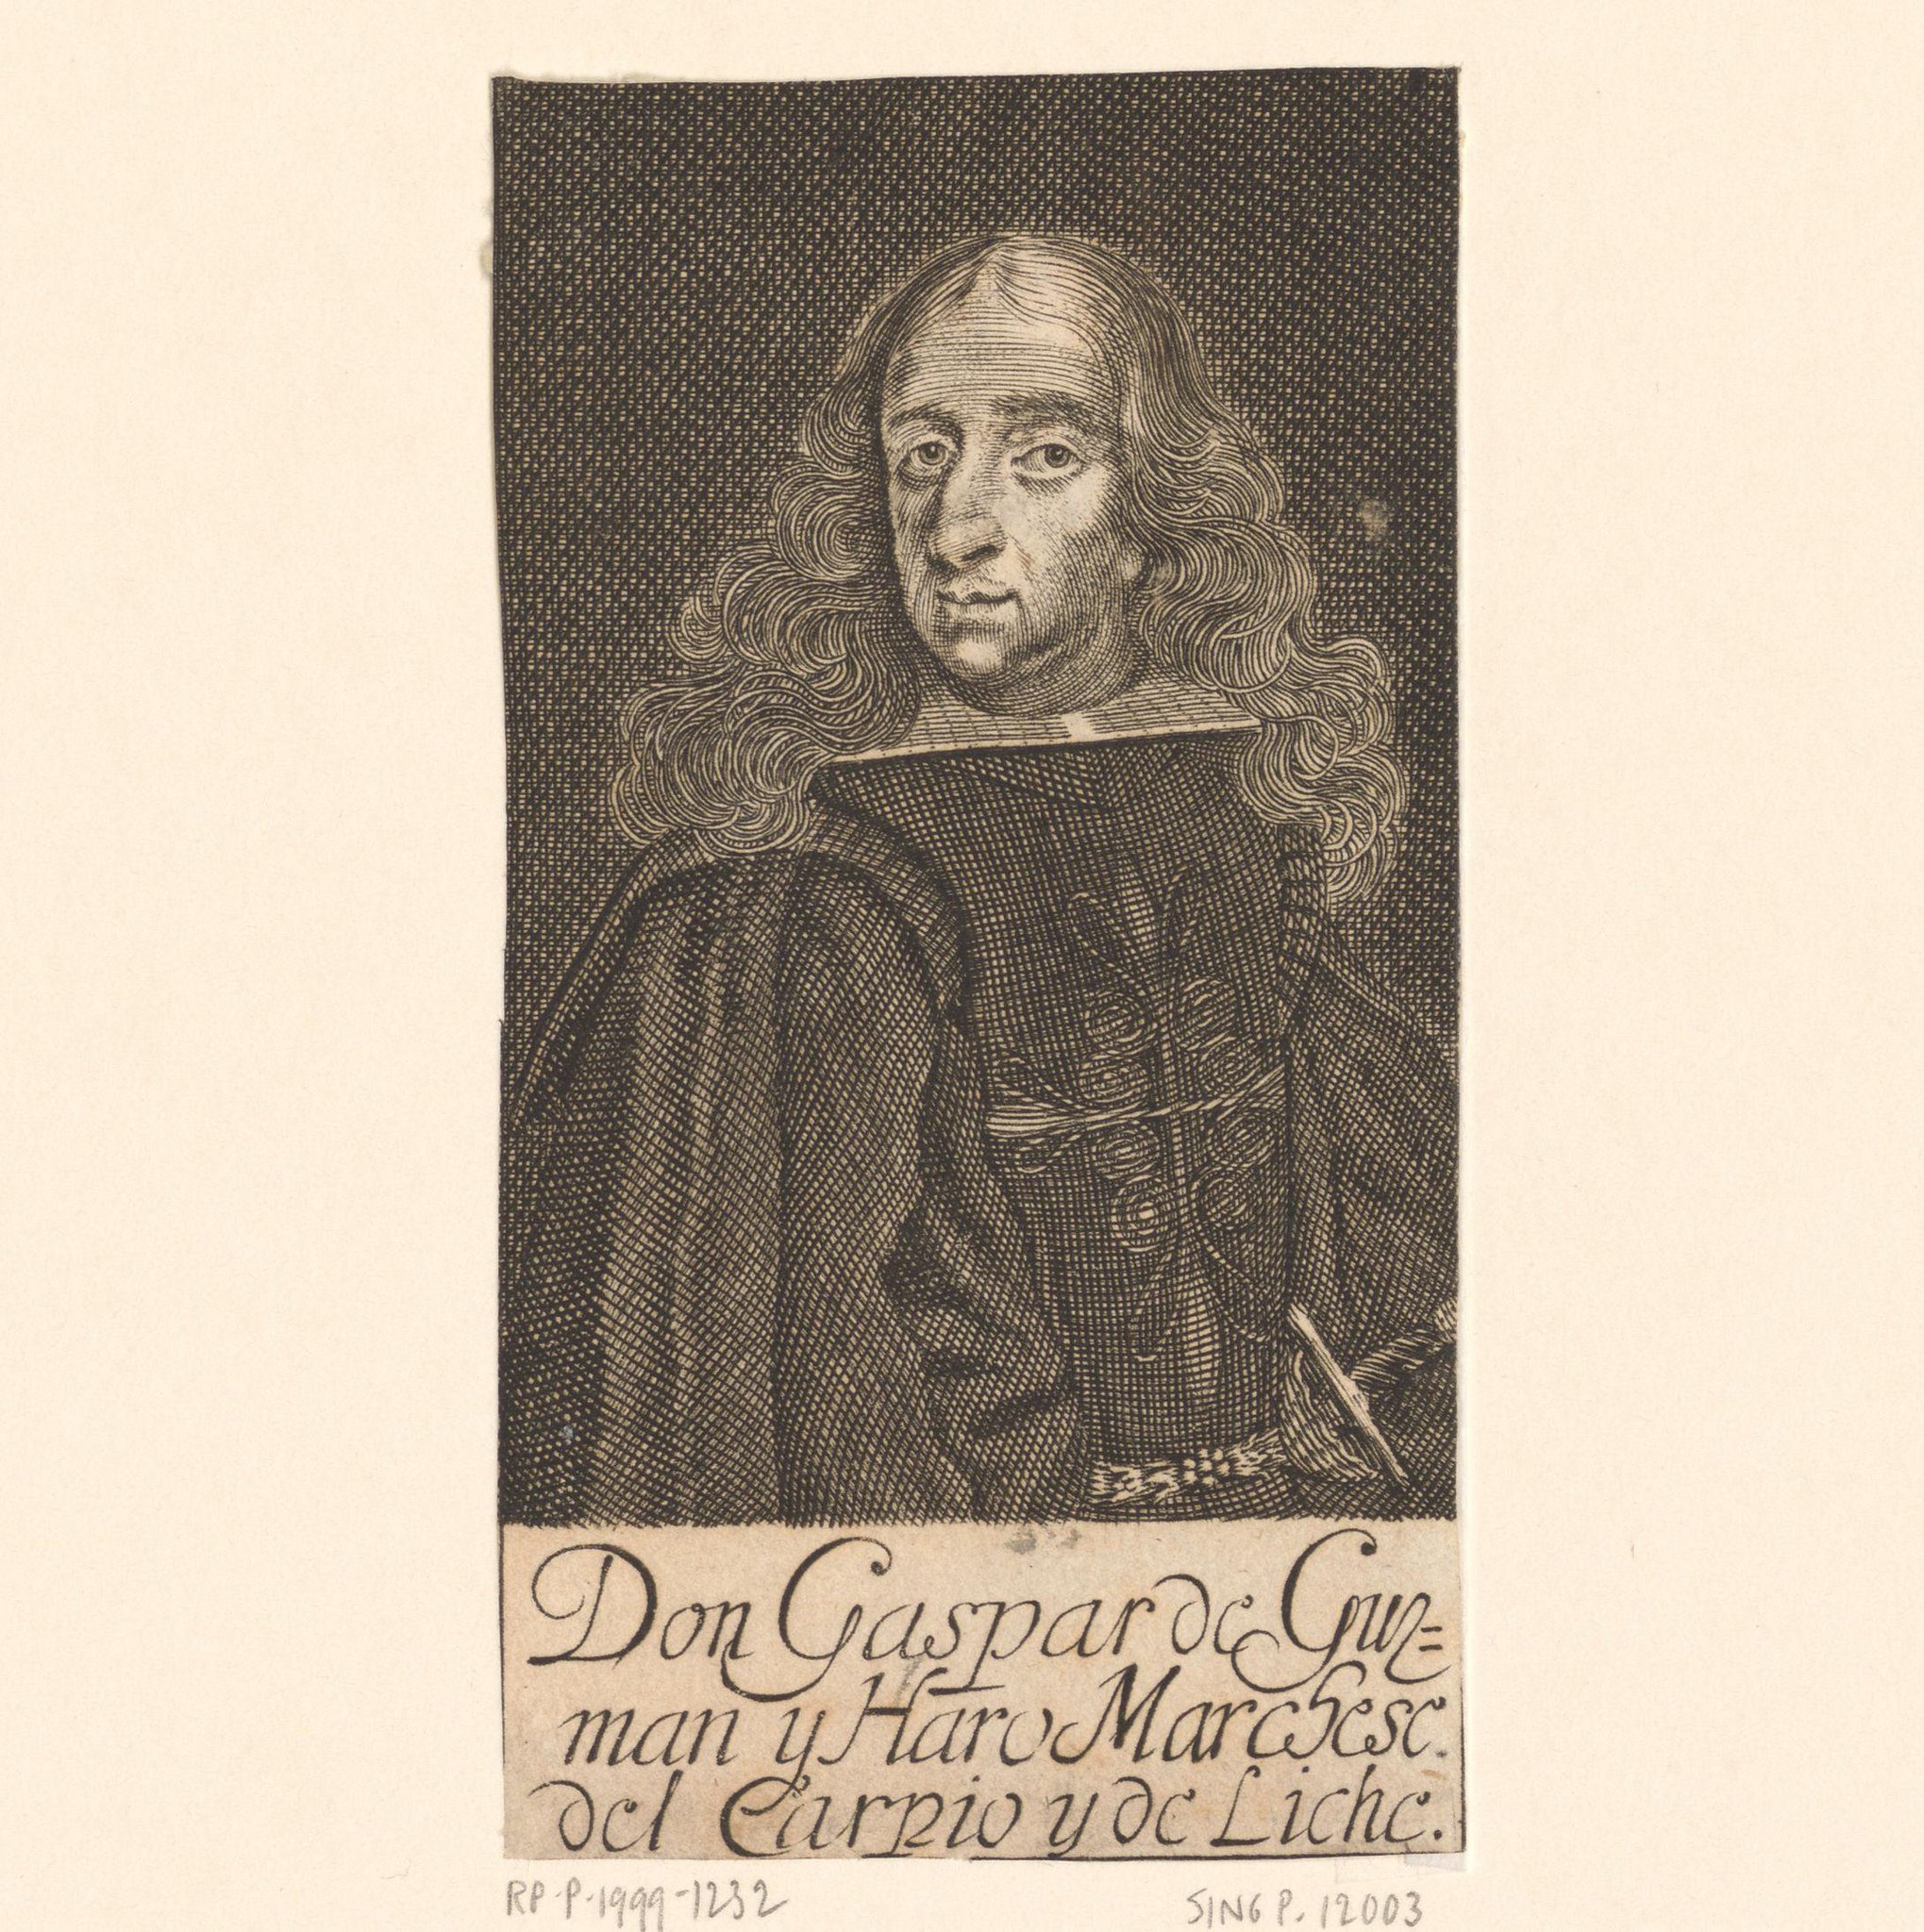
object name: print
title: Portret van Gaspar de Haro y Guzmán, markies van Carpio en Liche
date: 1703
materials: paper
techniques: engraving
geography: leipzig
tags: politician, gaspar de haro y guzmán (markies van carpio en liche), historical persons, politician, e.g. party leader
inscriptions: collector's mark: Lugt 2228, collector's mark: Lugt 2760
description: Prent uit: Jumel de Barneville d' Aulnoy, Marie Catherine le. Spanische Staats-Geschichte beschrieben von der Gräfin d'Aunoy (...). Leipzig: Thomas Fritsch, 1703, p. 12.